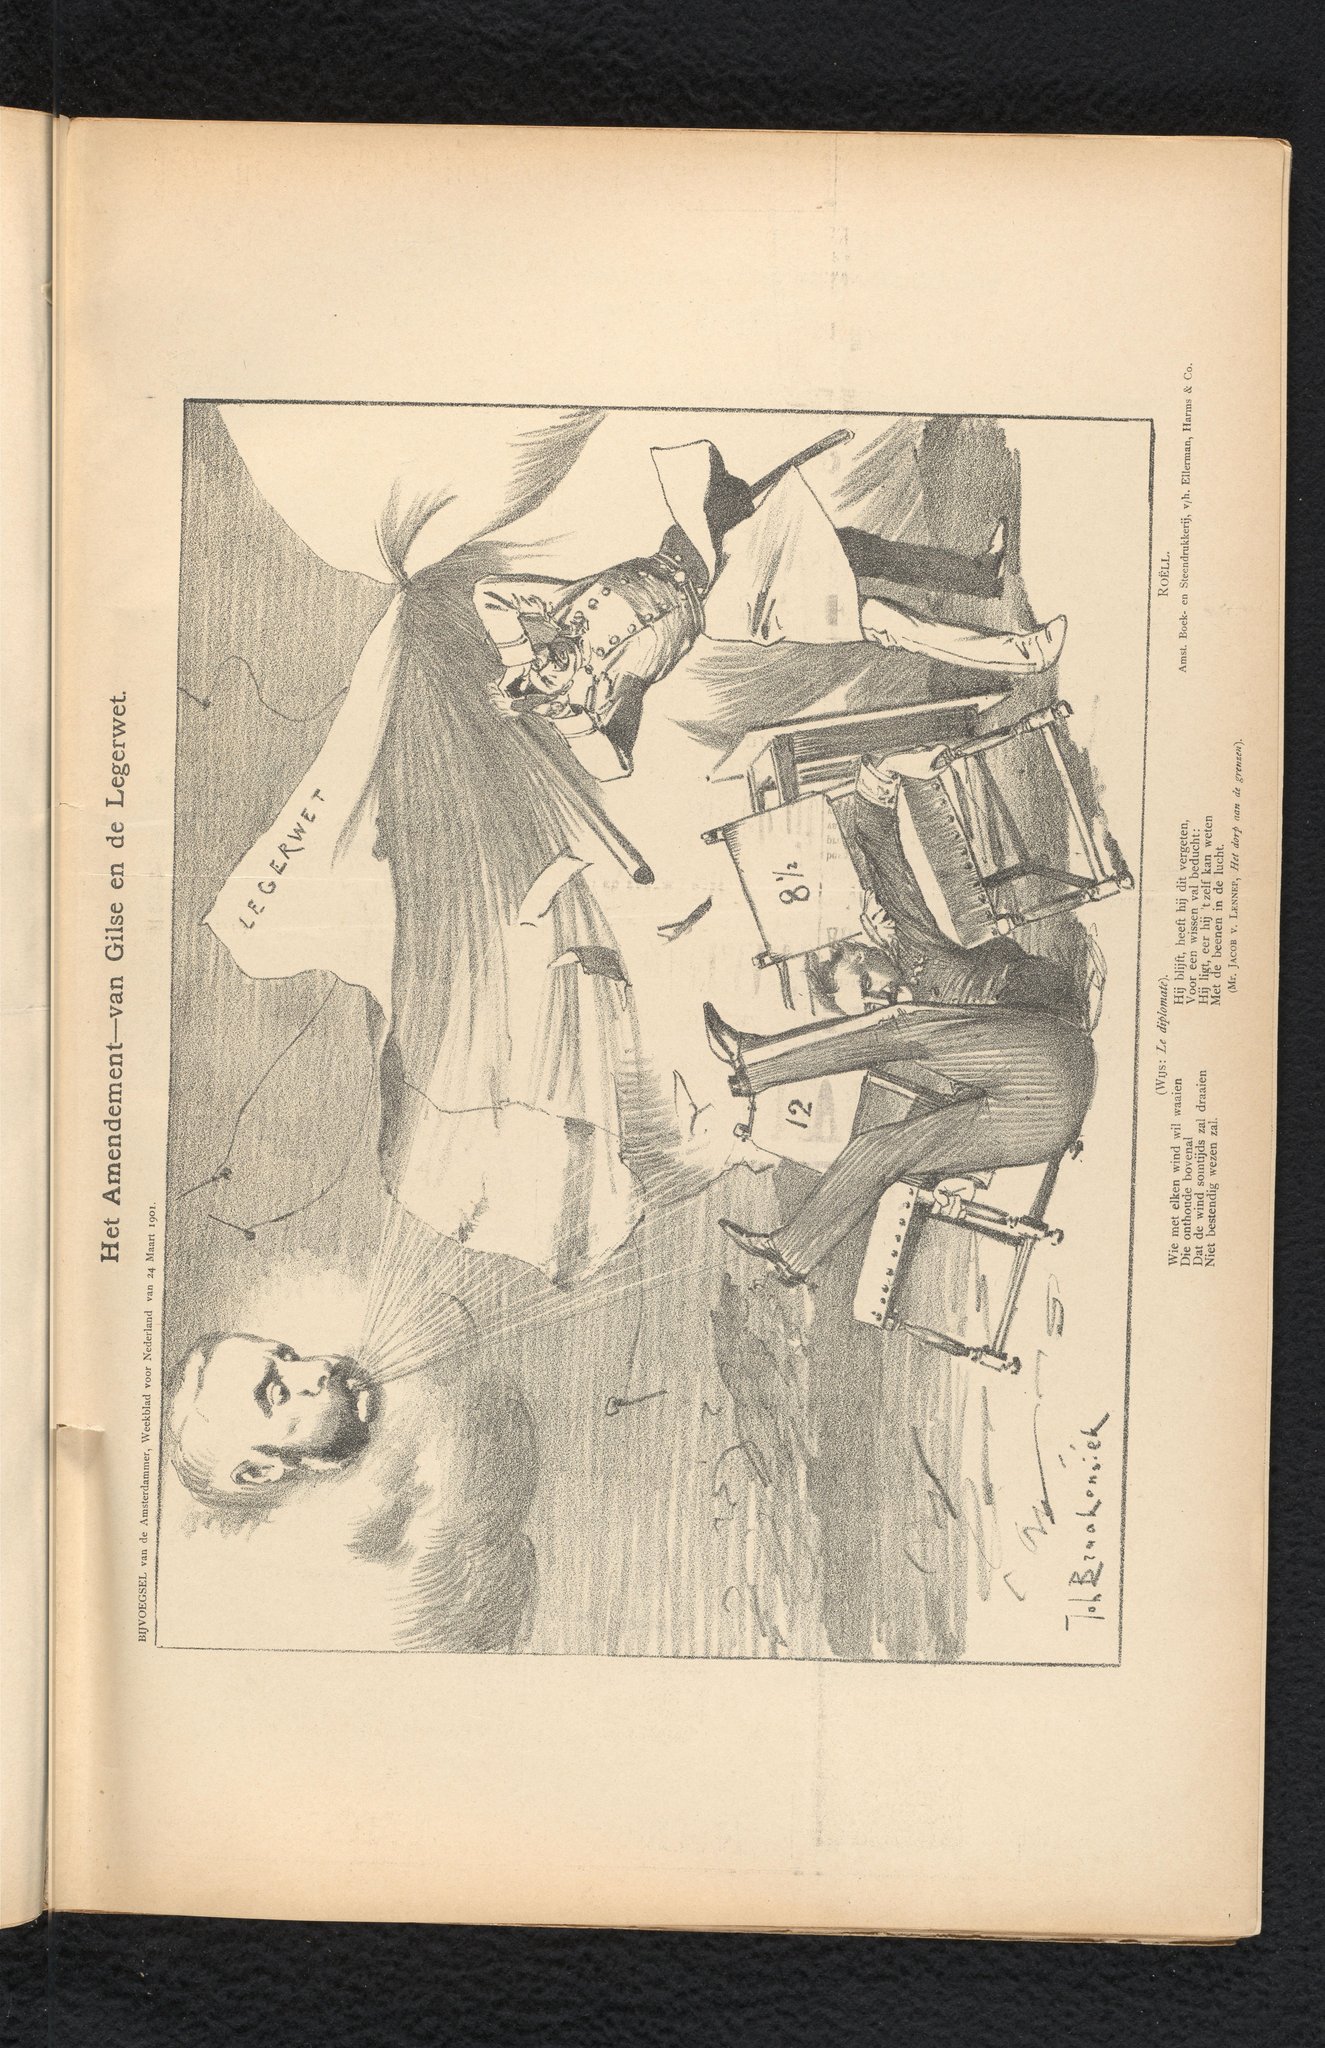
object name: cartoon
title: Het Amendement - Van Gilse en de Legerwet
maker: johan braakensiek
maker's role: draughtsman, print maker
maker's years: 1858-1940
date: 1901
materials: paper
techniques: lithograph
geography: amsterdam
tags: klundert, utrecht, naval officer, military service, (military) camp with tents, storm on land, political caricatures and satires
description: Kamerlid Jan Albert van Gilse blaast uit de wolken met zijn amendement over verkorting van de diensttijd de legertent van Minister van Oorlog Eland en Minister van Marine Roëll omver.